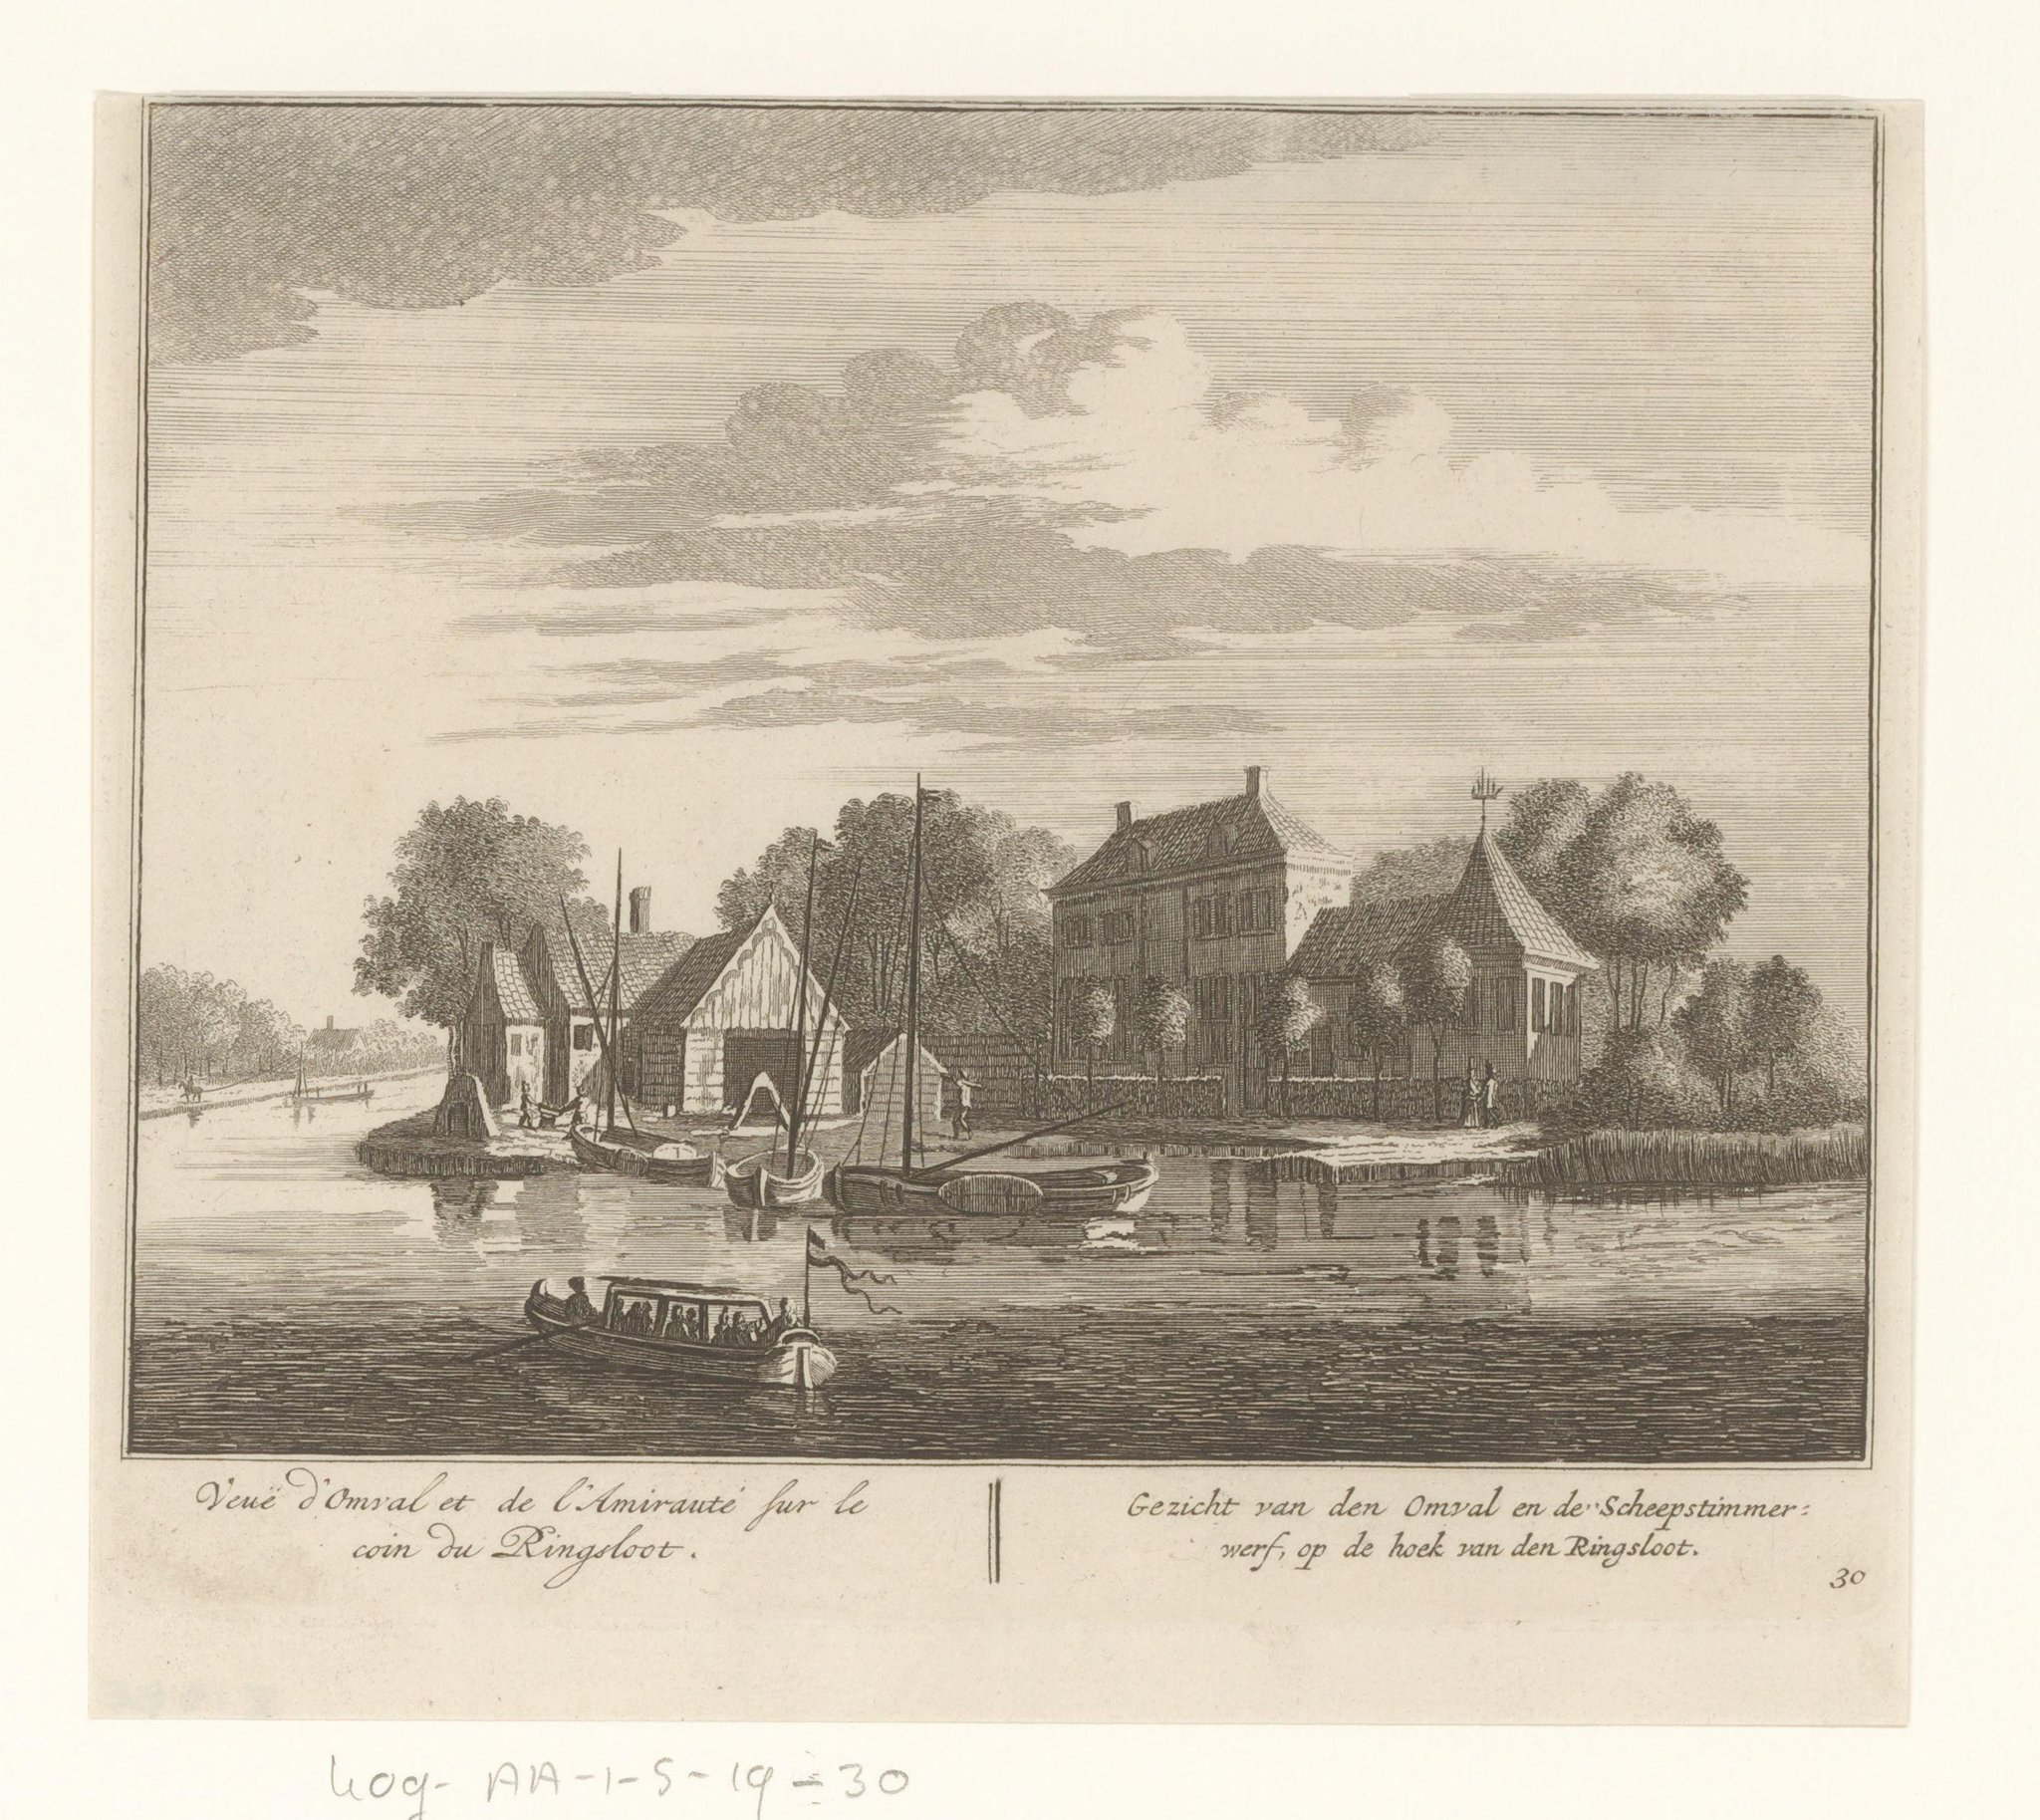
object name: print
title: Gezicht op de Scheepstimmerwerf op de hoek van de Ringsloot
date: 1730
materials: paper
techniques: etching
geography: amsterdam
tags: sailing-ship, sailing-boat, city-view in general; 'veduta', river, pier, quay, wharf, boat propelled by man or animal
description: Prent waarschijnlijk uit: Tijsens, Gijsbert. Hollands Arcadia, of de vermaarde rivier den Amstel (...) naar 't léven getekend en in 't ligt gebragt door Abraham Rademaker (...). Amsterdam: Leonardus Schenk, 1730.